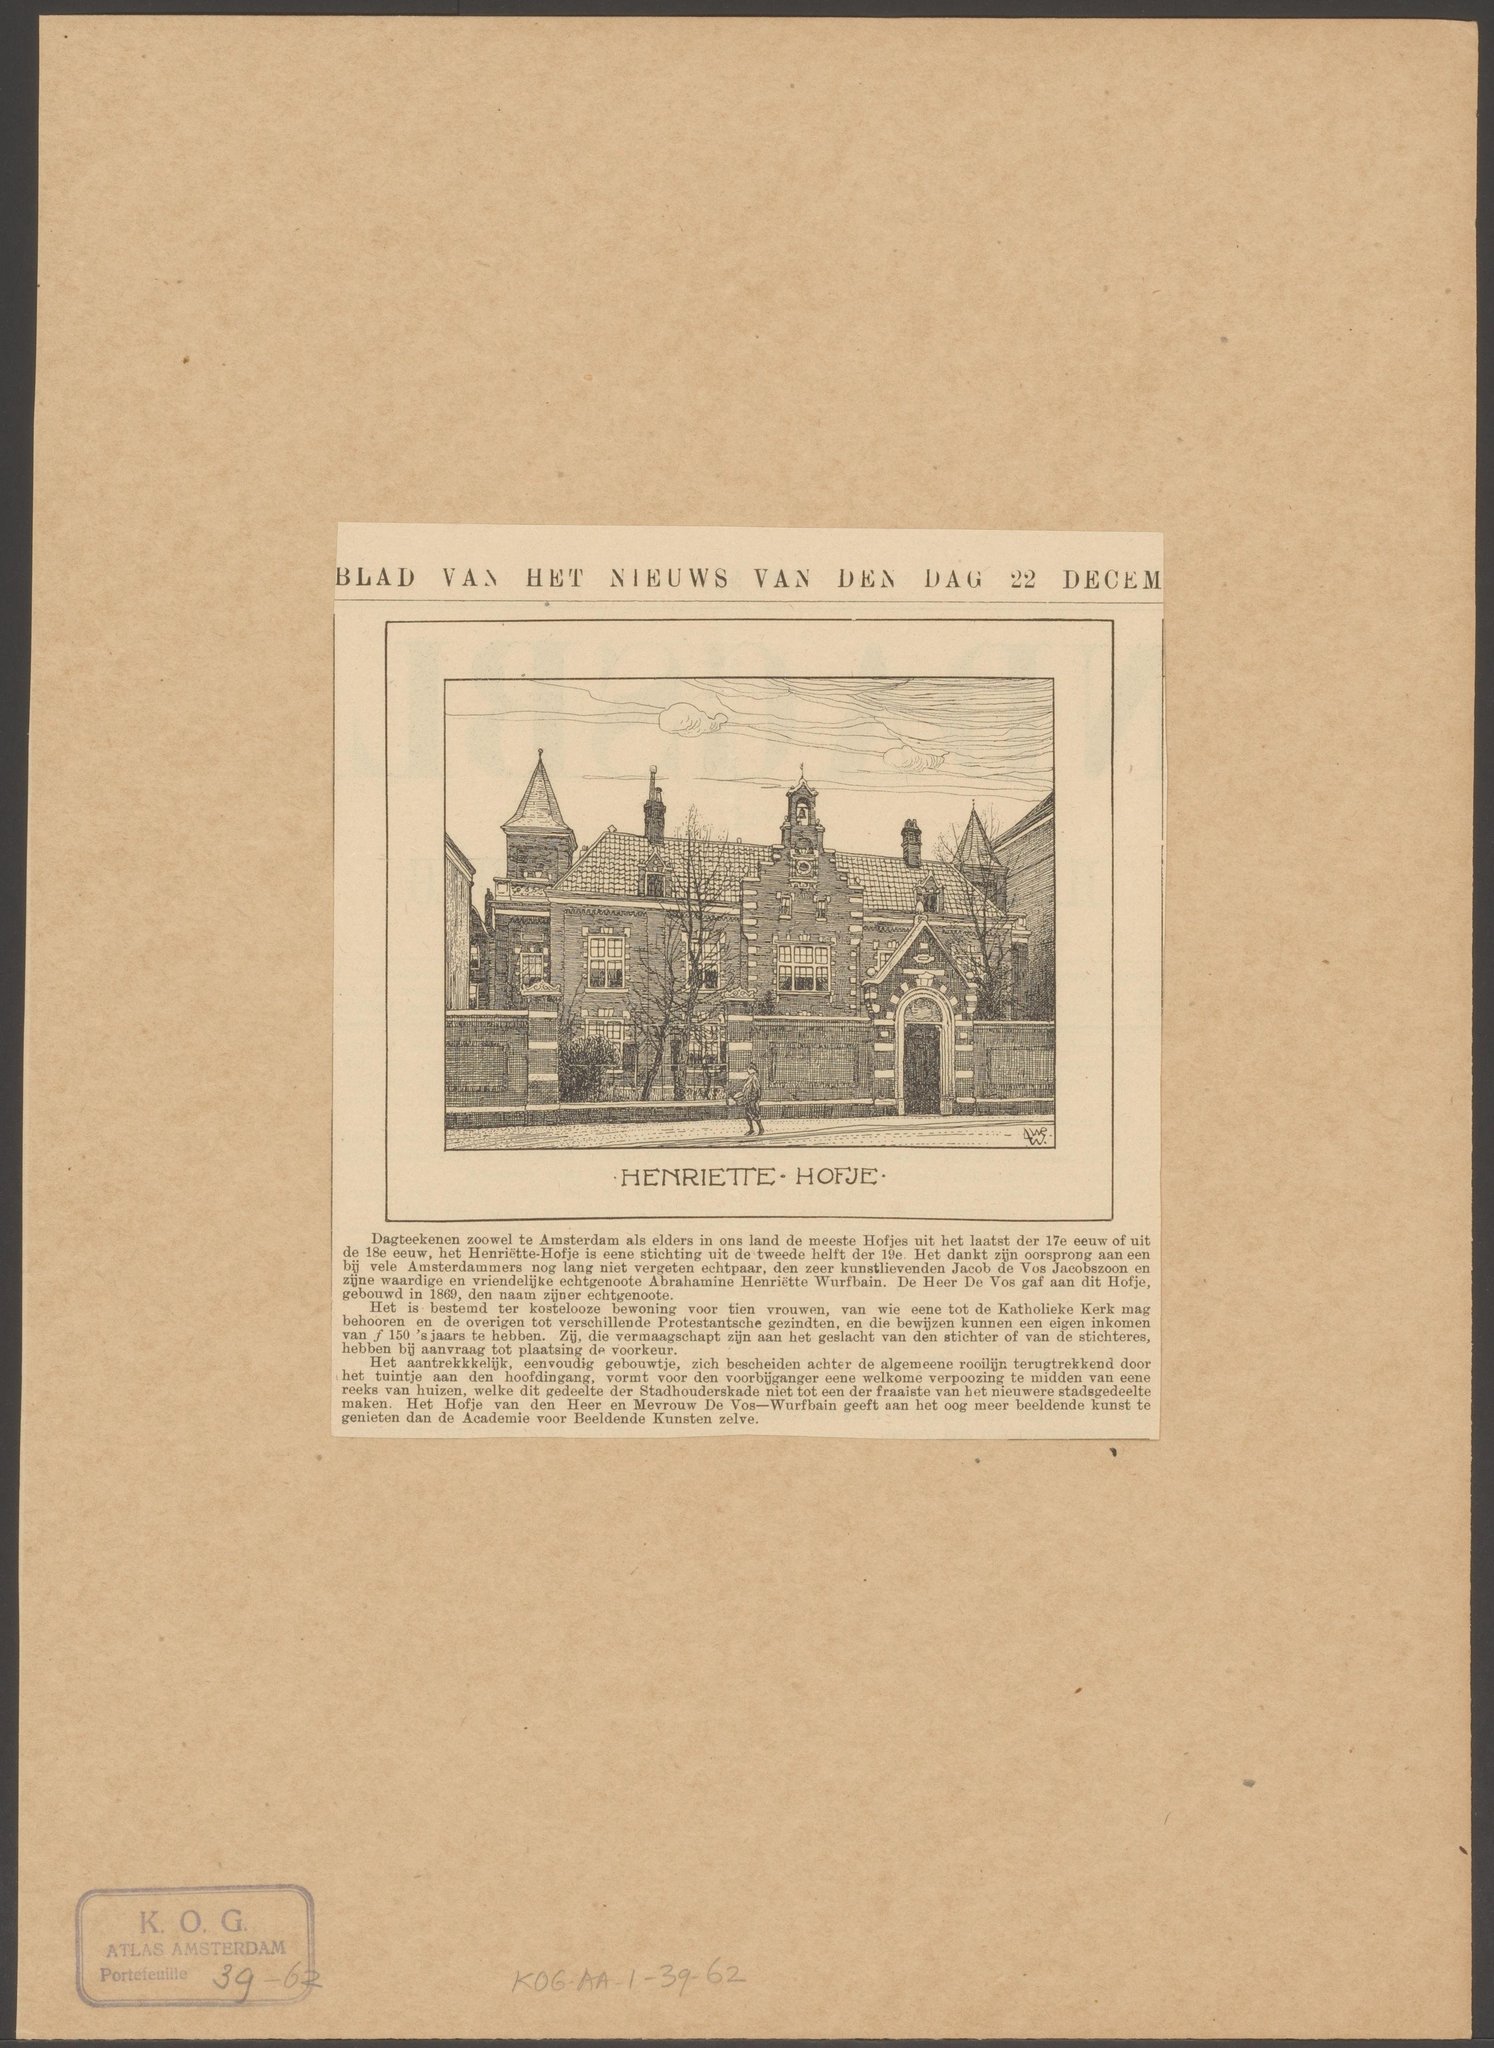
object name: photomechanical print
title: Gezicht op het Henriëttehofje te Amsterdam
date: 1907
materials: paper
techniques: letterpress printing, line block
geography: netherlands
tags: alms-house (dutch: 'hofje'), street (+ city(-scape) with figures, staffage)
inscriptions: collector's mark: Lugt 1641b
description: Onderwerpsrubriek binnen de Atlas Amsterdam: Armwezen en liefdadige instellingen: III. Verschillende gestichten en instellingen / Hofjes: Hamershuisjes - Henriëtte-Hofje.